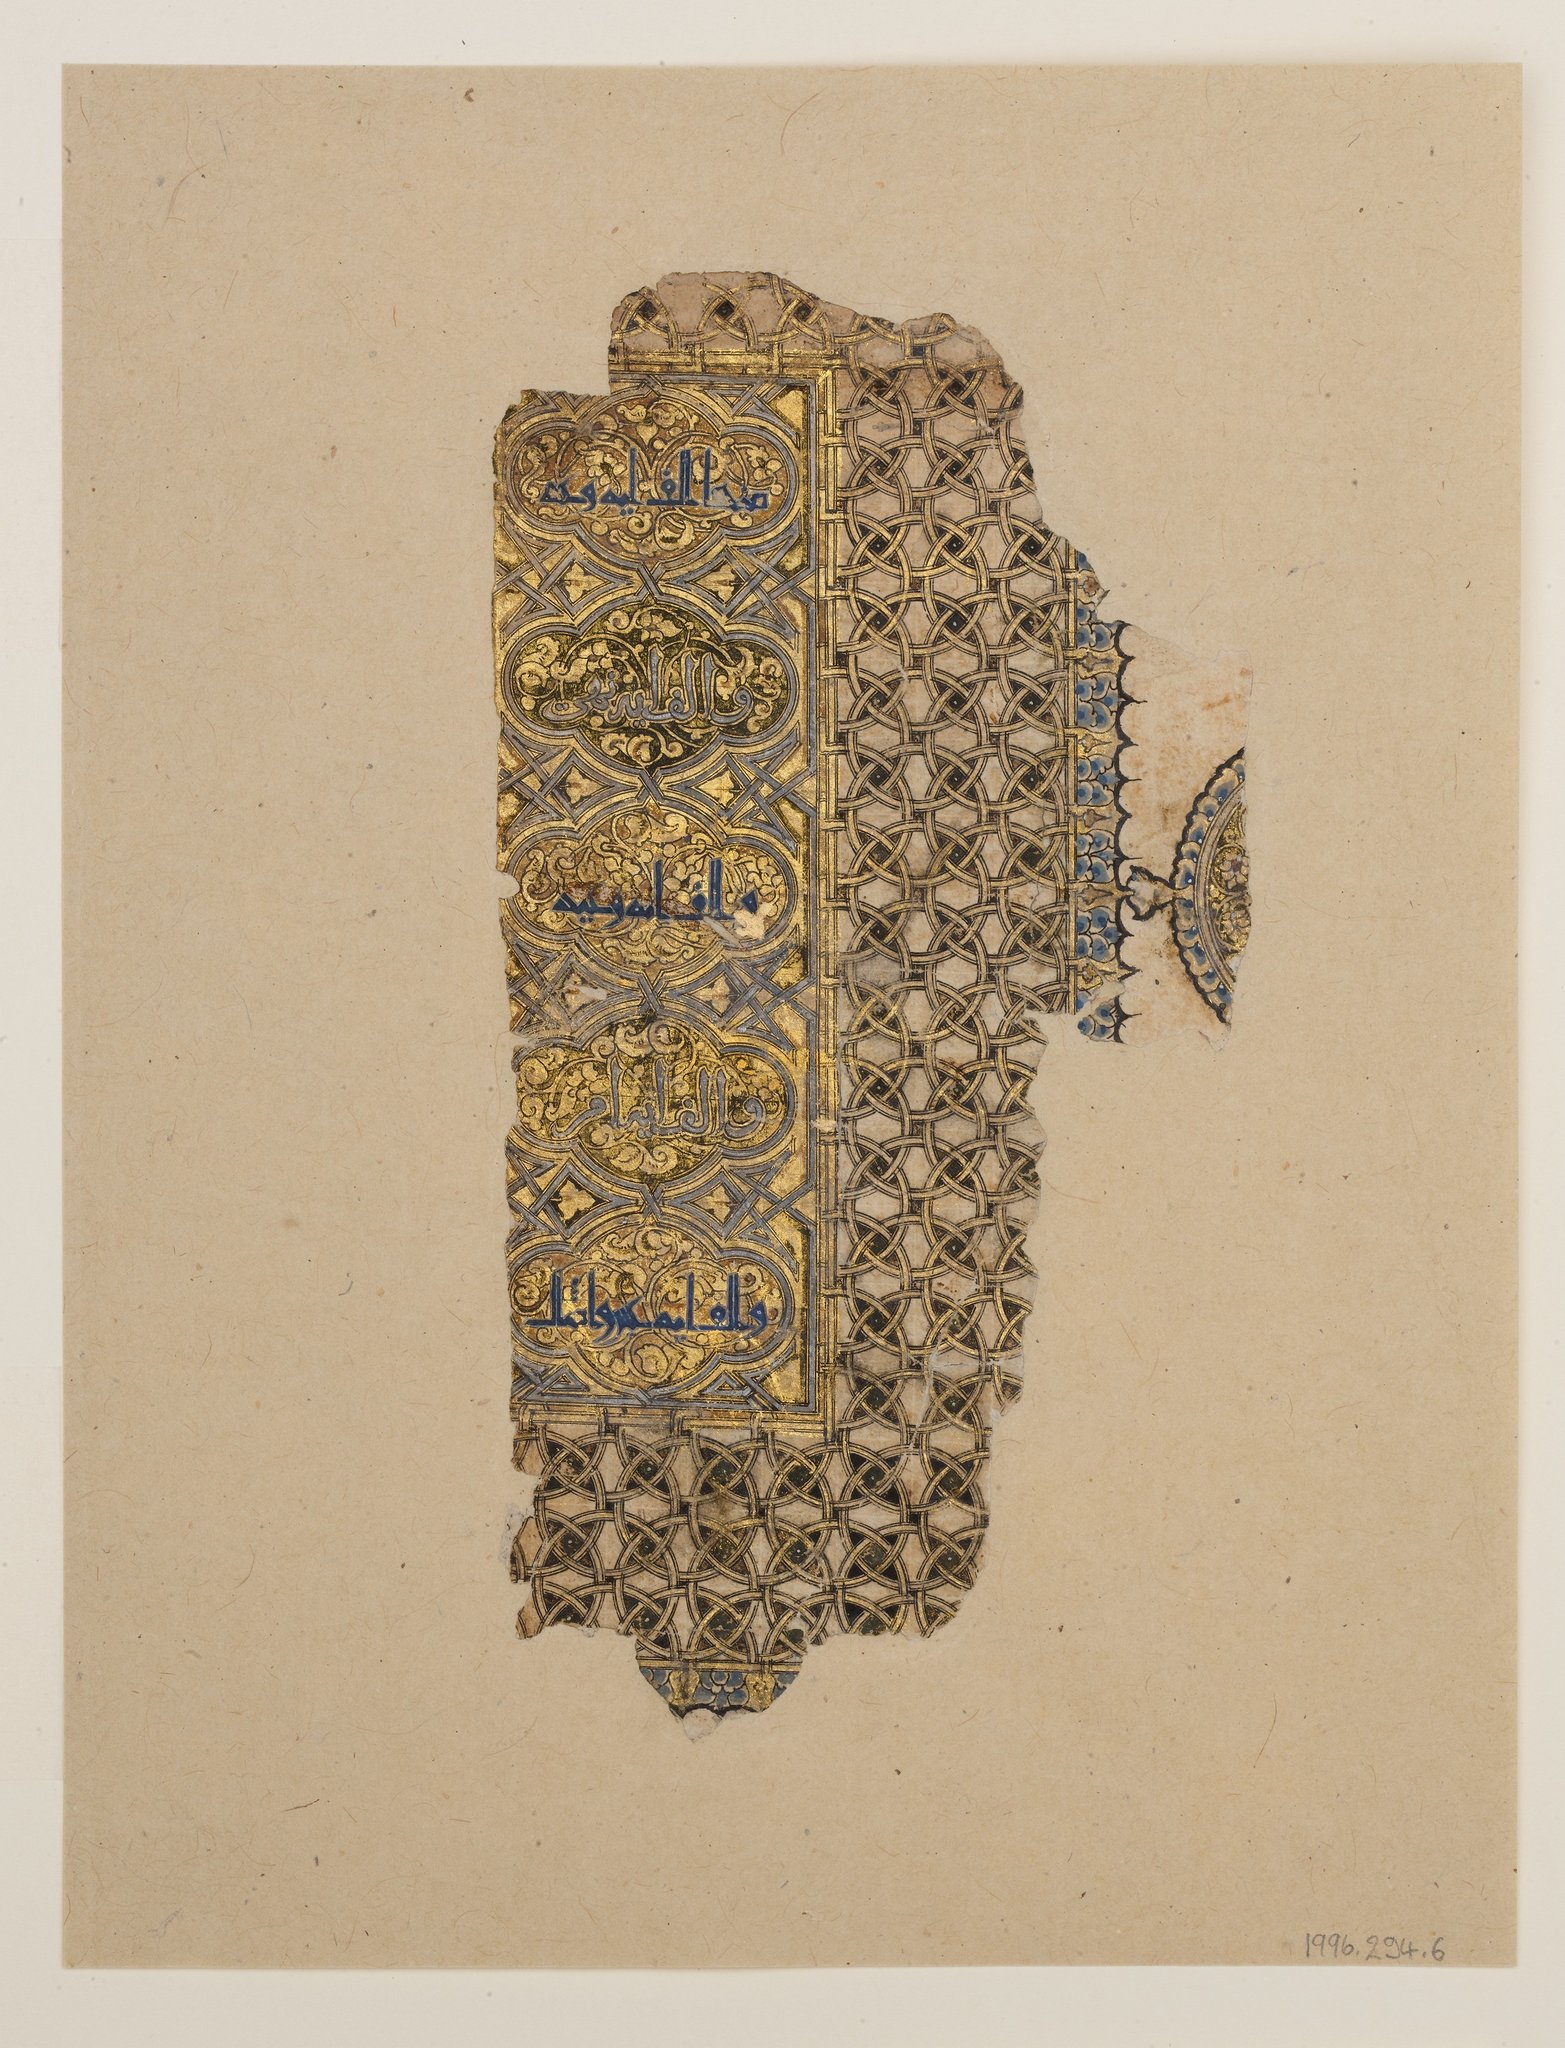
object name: folio from a non illustrated manuscript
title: Folio from a Qur'an Manuscript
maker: muhammad al-zanjani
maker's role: calligrapher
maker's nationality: iranian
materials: gold, ink, paper, watercolor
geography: iran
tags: qur'an,calligraphy